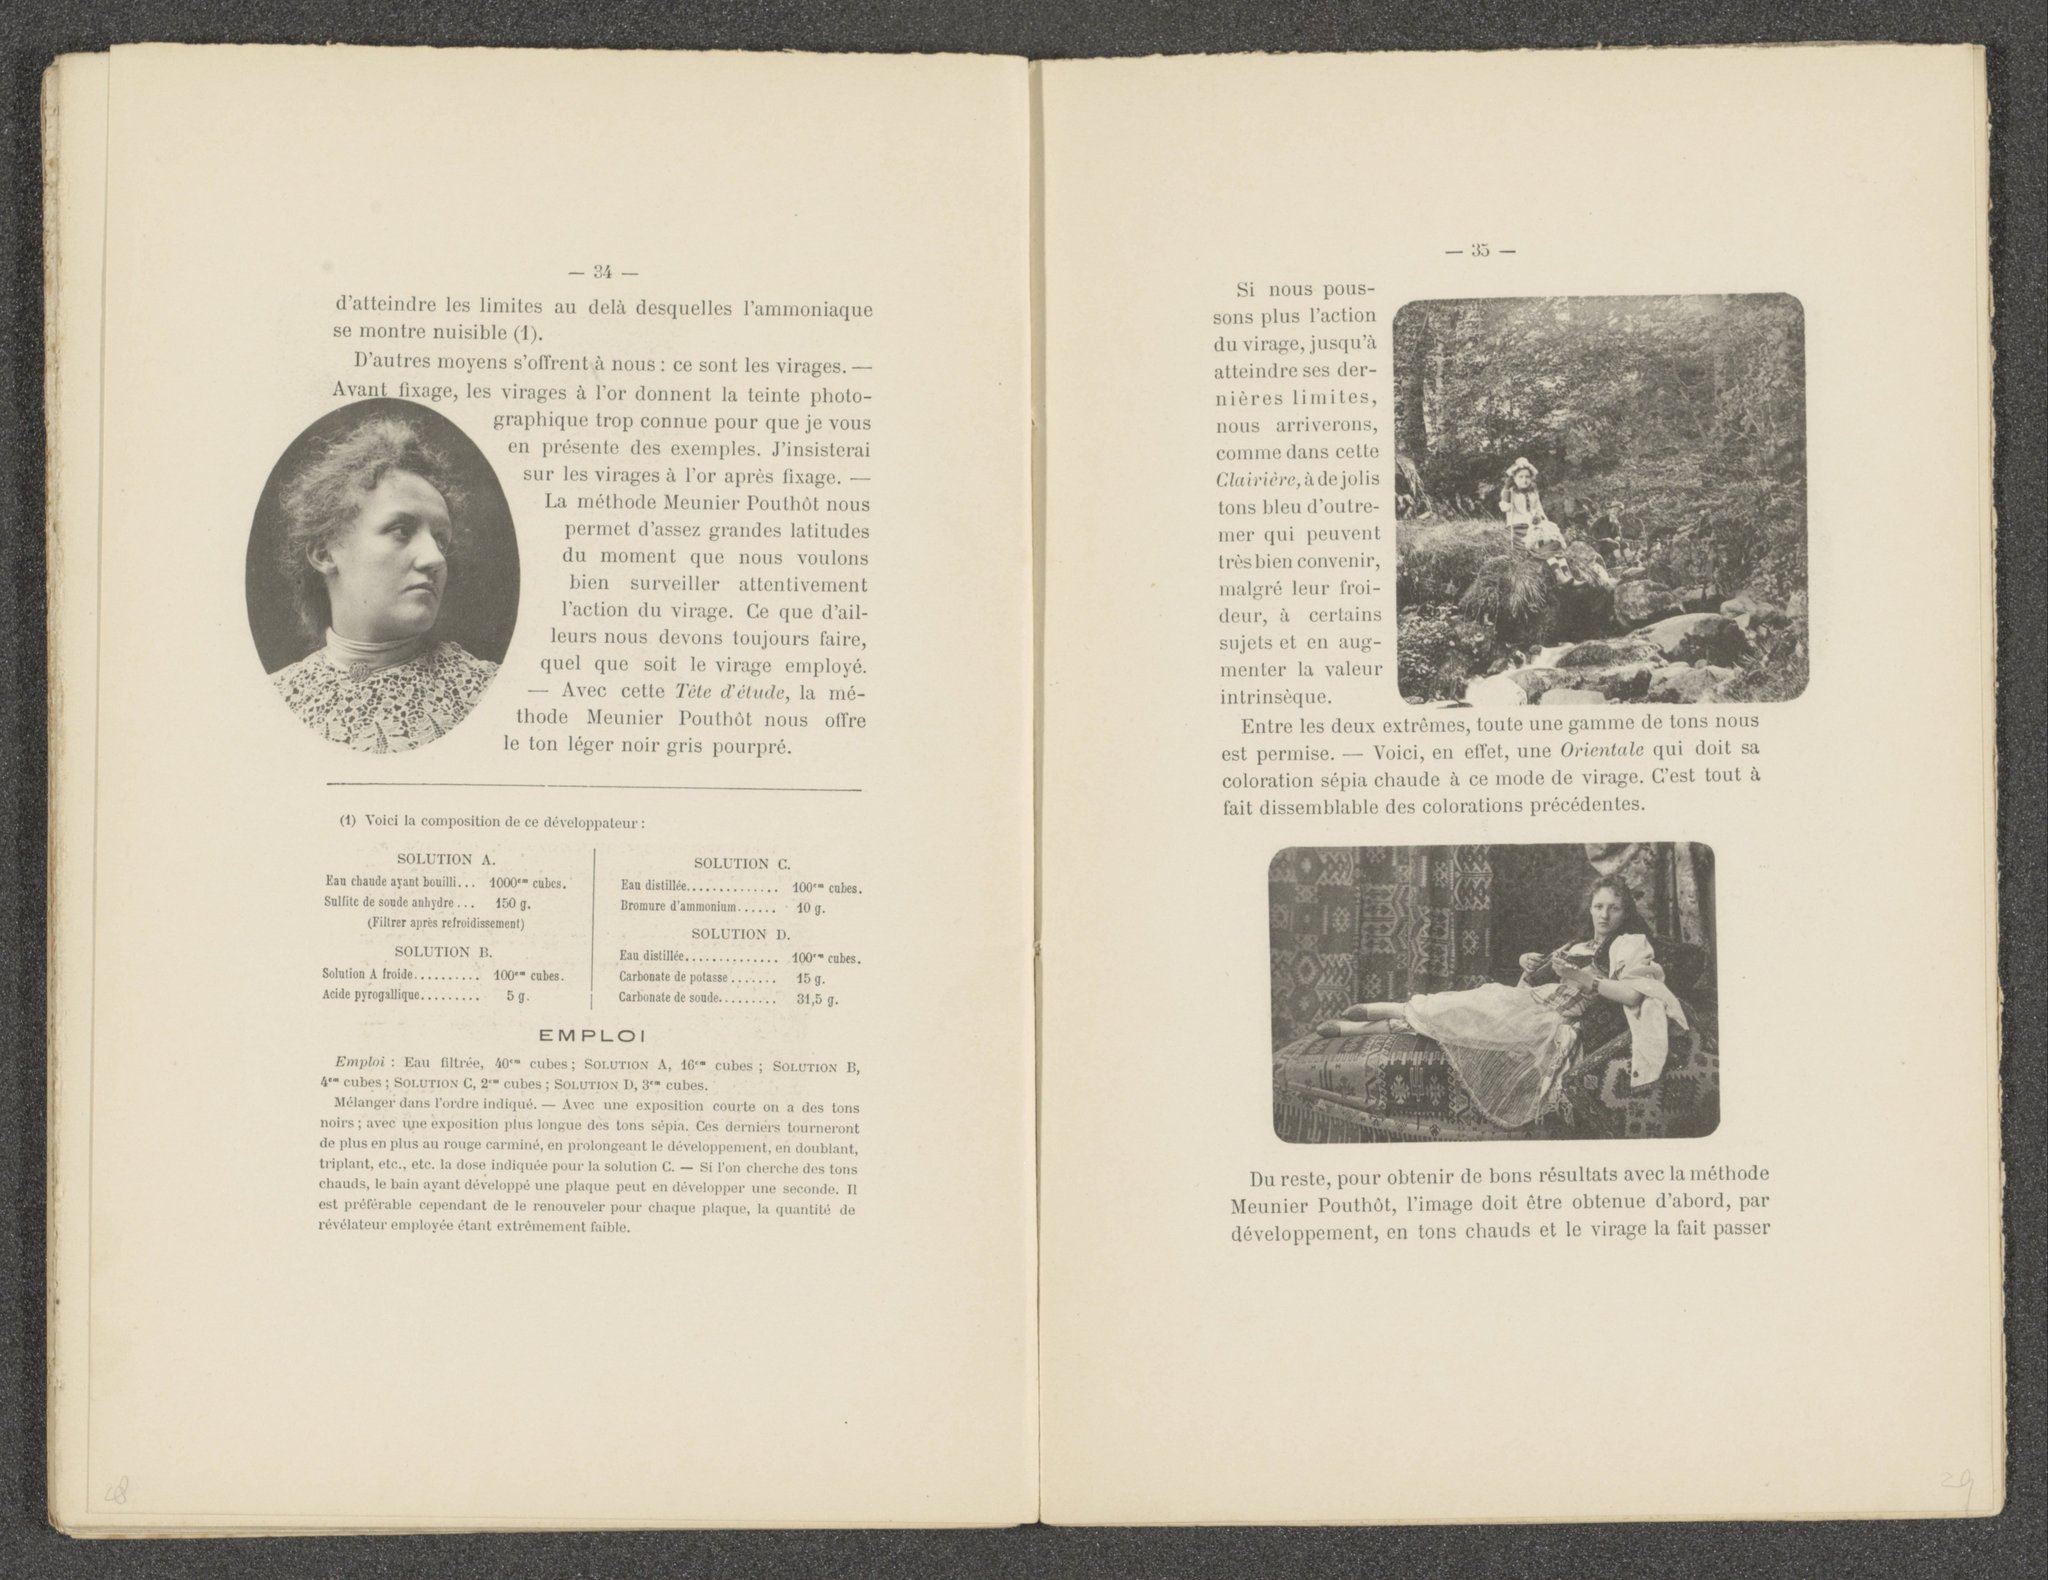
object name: photomechanical print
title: Twee kinderen langs een beek en een liggende vrouw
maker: Anonymous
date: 1886-1896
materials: paper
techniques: photograph, printing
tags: child, brook, lying figure - aa - female human figure